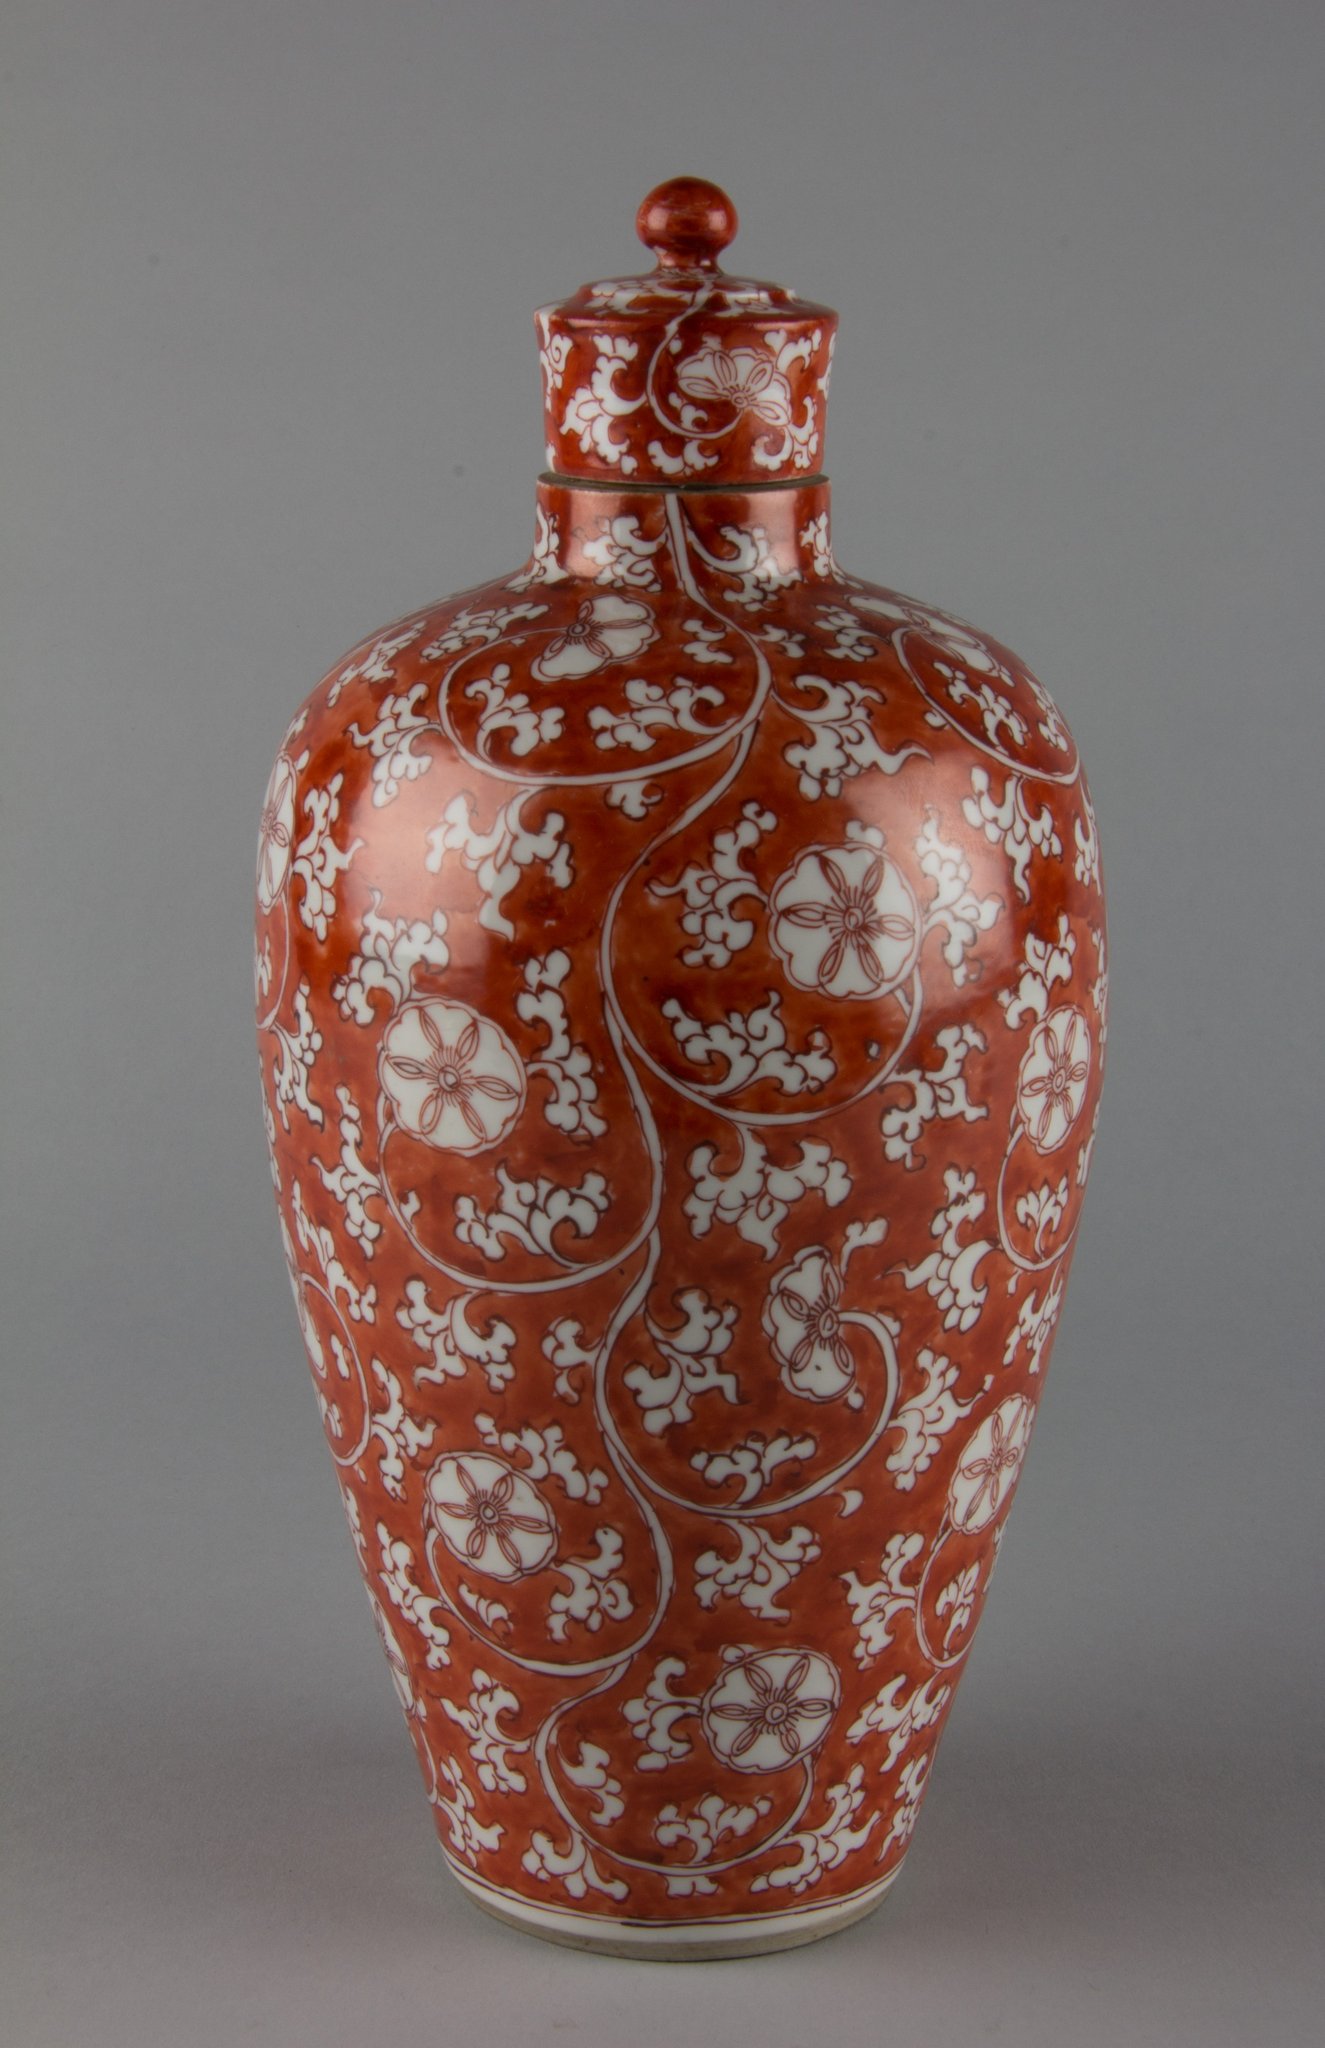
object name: covered bottle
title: Covered bottle with floral scrolls (one of a pair)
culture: chinese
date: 1701-1800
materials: enamel, porcelain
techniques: overglaze, painting